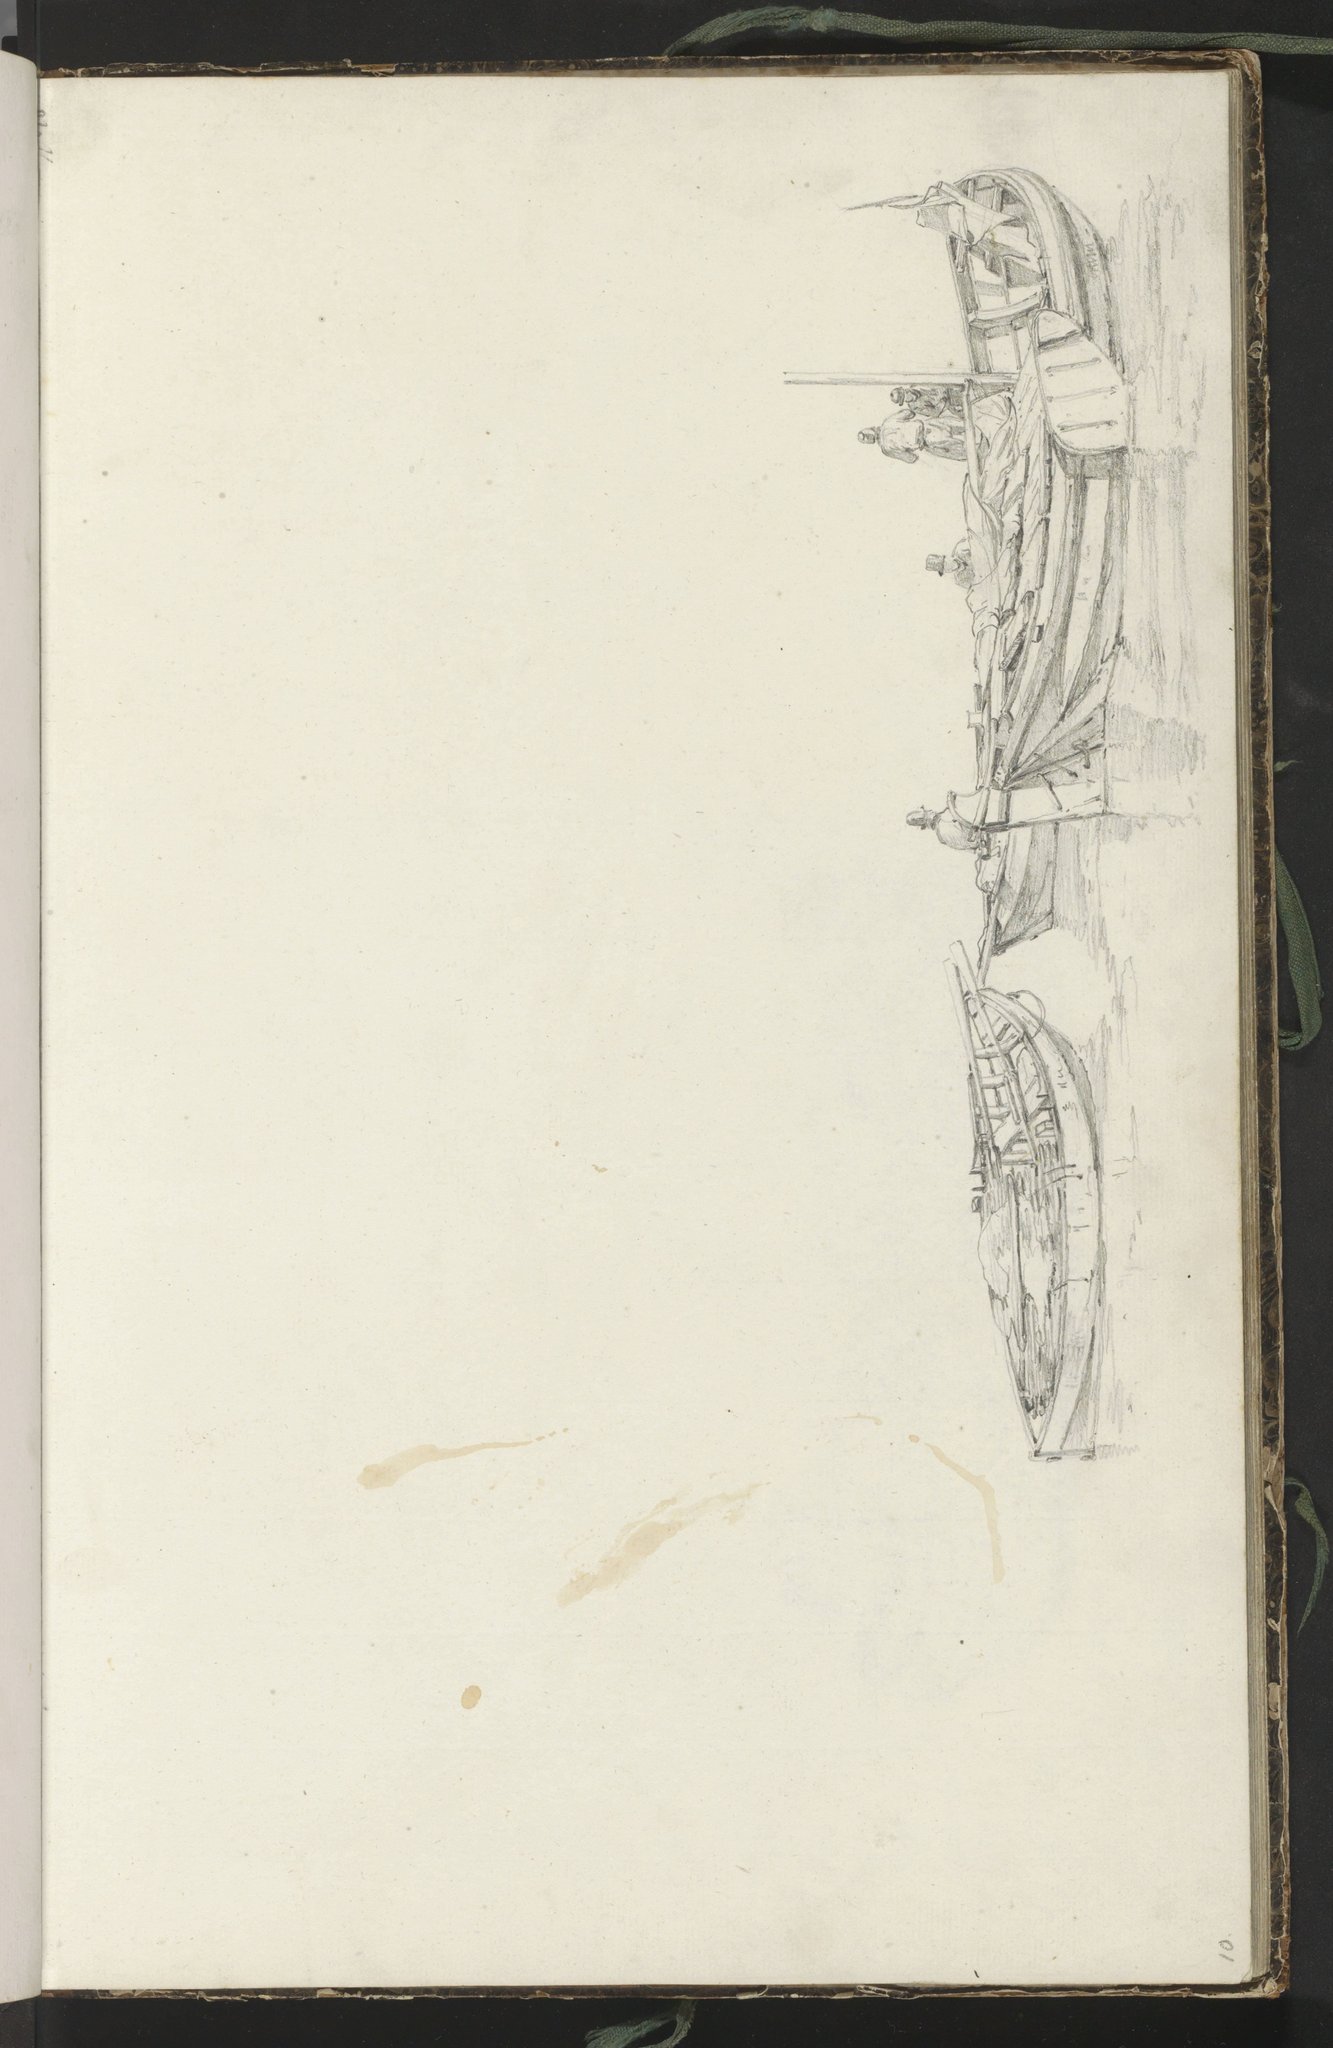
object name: sketchbook leaf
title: Drie zeilboten met gestreken zeilen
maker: johannes christiaan schotel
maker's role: draughtsman, painter, print maker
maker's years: 1787-1838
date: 1797-1838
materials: paper, pencil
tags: sailing-ship, sailing-boat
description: Op één van de drie boten staan en zitten vier mannen, mogelijk twee passagiers en twee bemanningsleden. Blad 10 recto uit een schetsboek met 44 bladen.